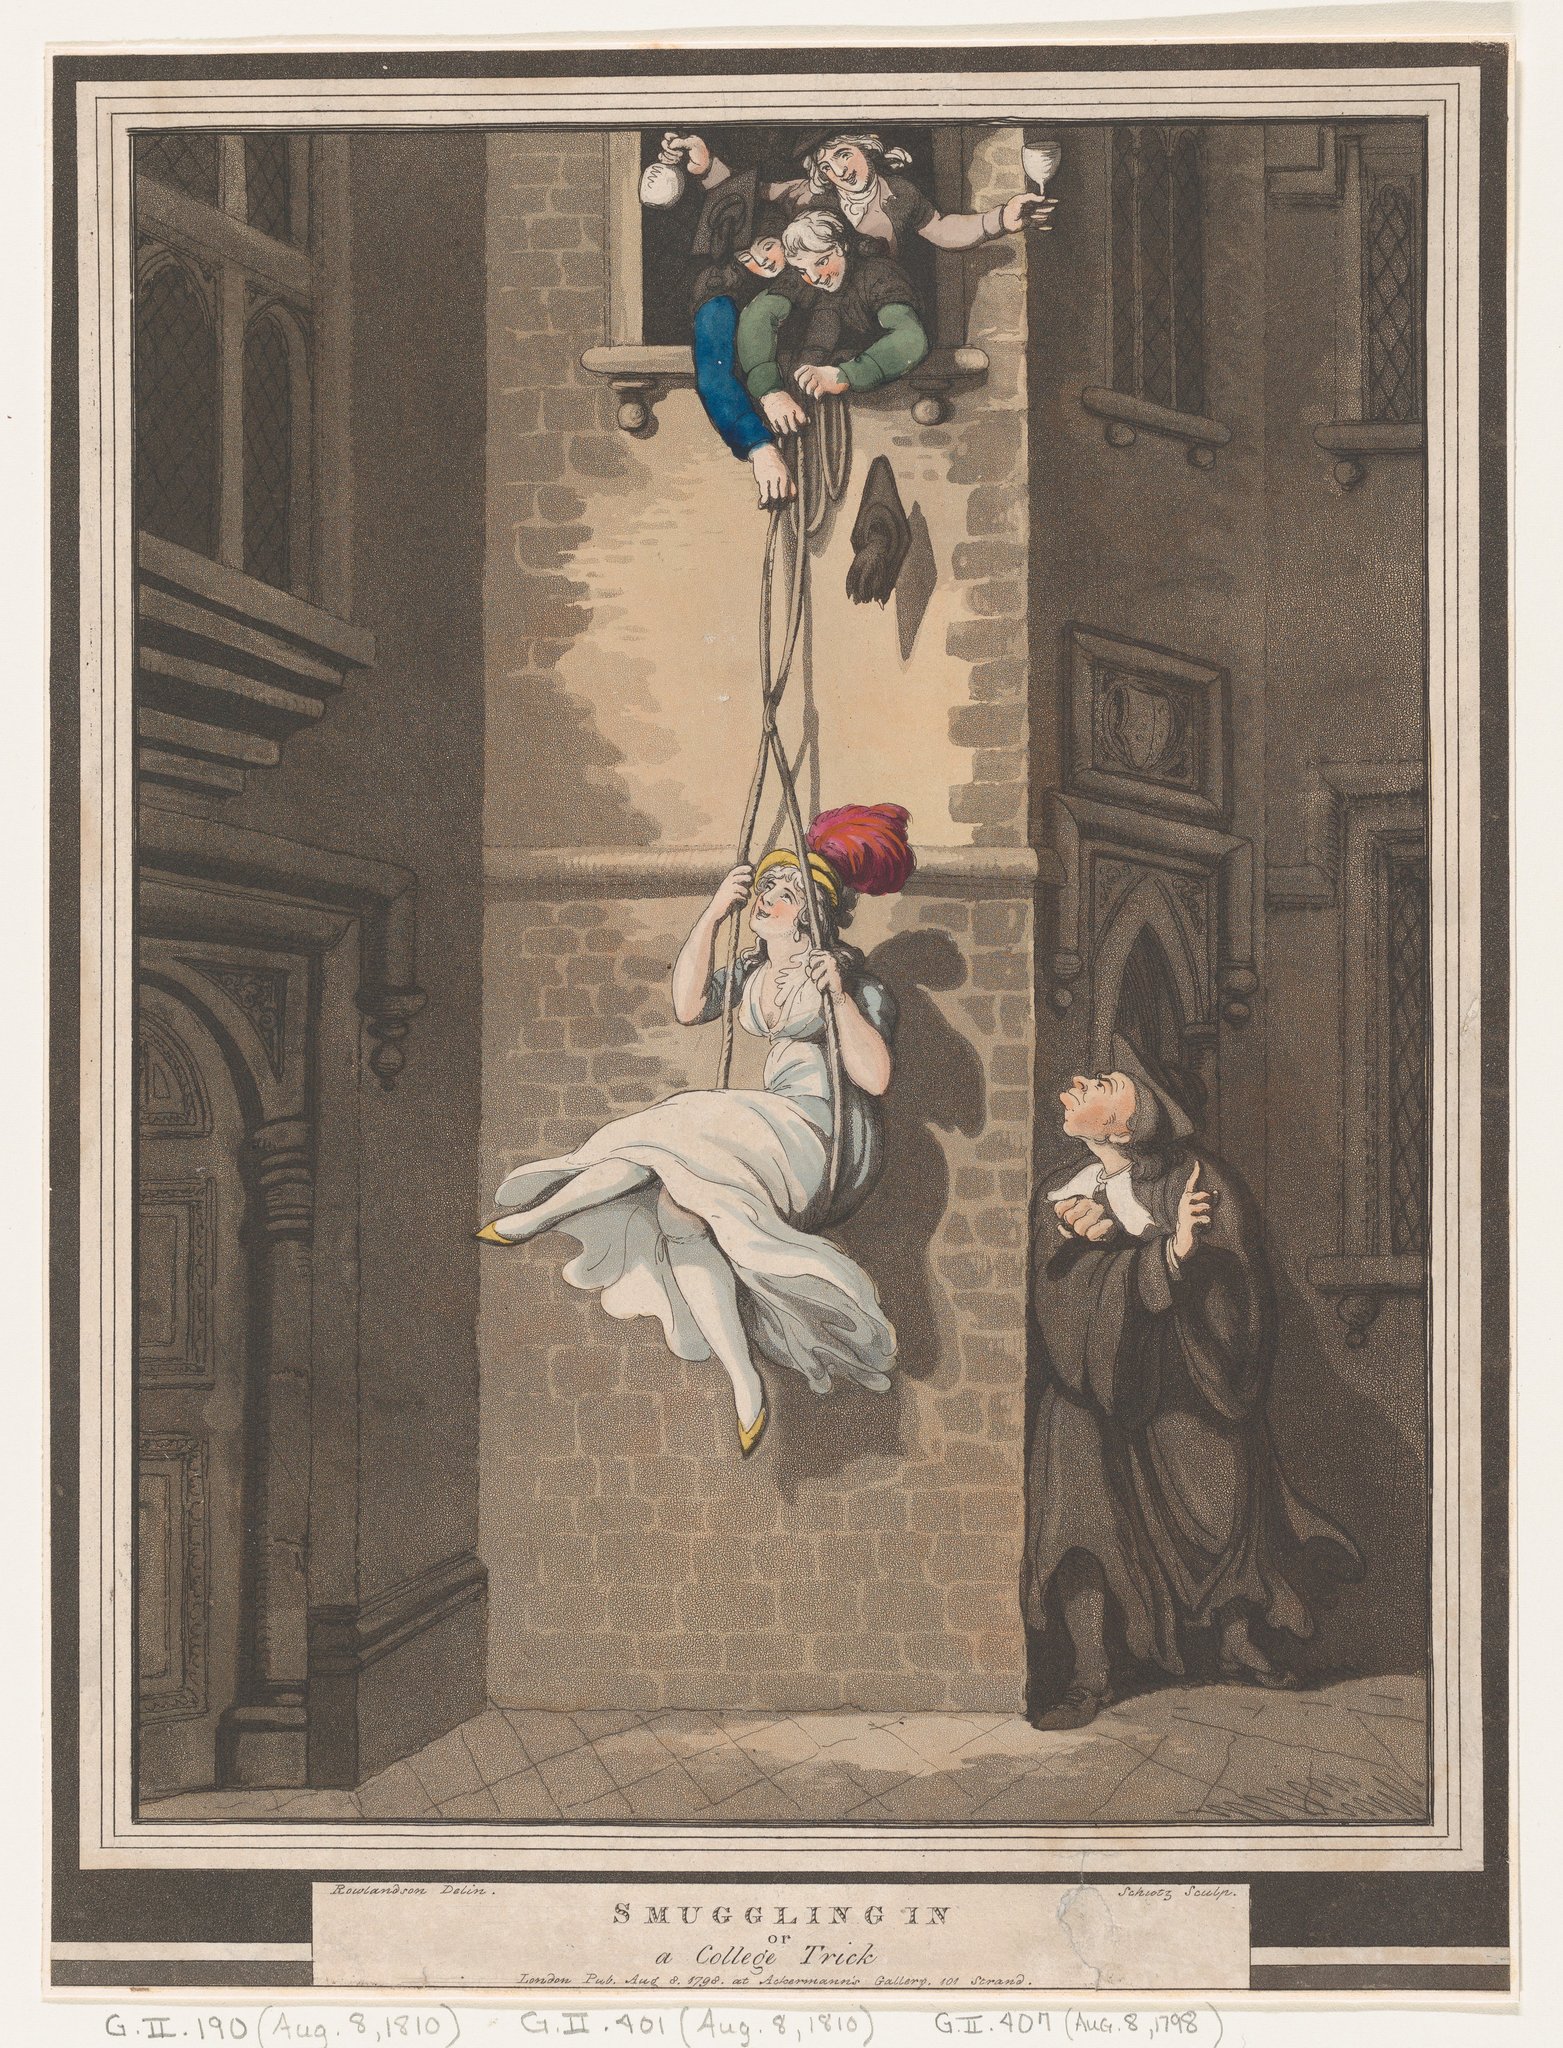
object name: print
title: Smuggling In, or A College Trick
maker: heinrich joseph schütz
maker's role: artist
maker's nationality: german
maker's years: 1800-1825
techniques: aquatint, etching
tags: buildings,men,women,drinking